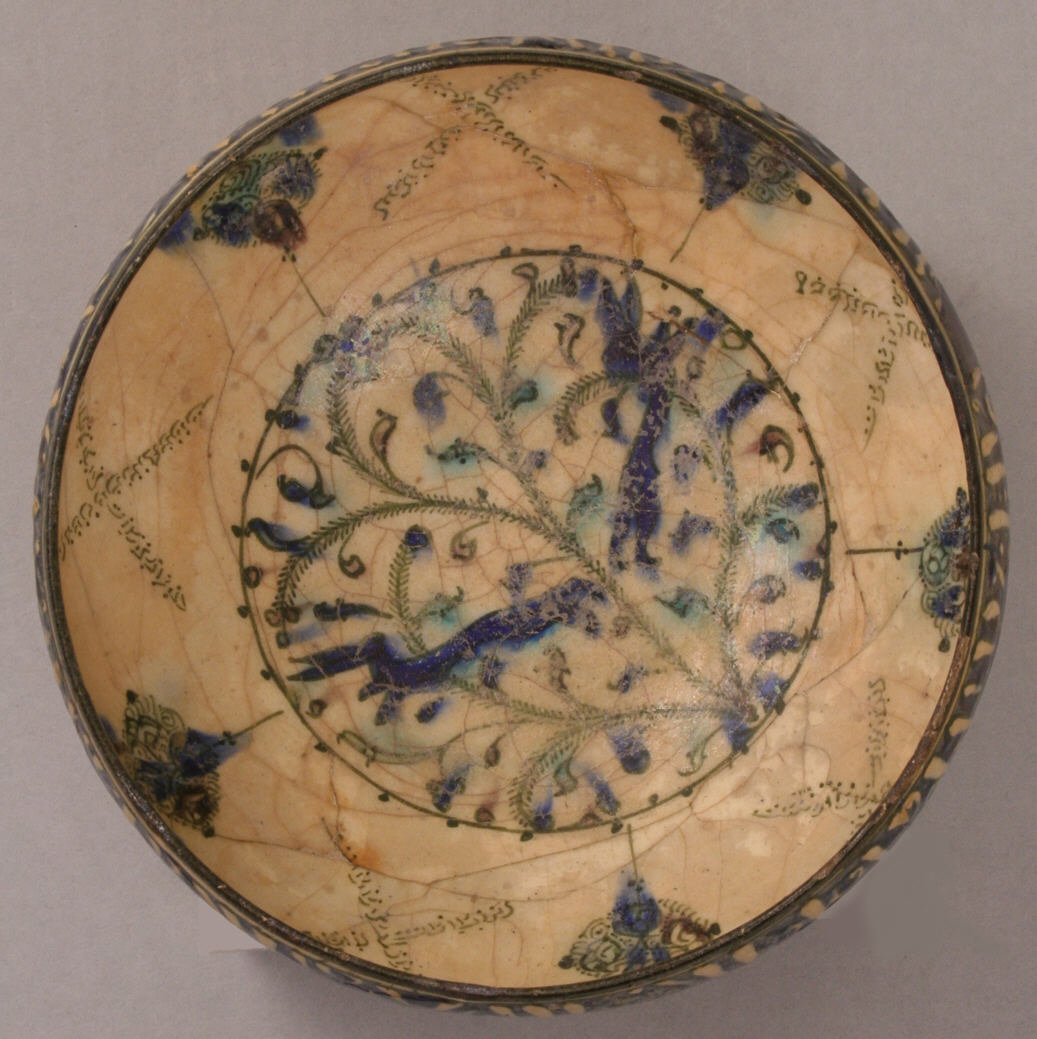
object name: bowl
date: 1301-1400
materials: earthenware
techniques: glazing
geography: iran